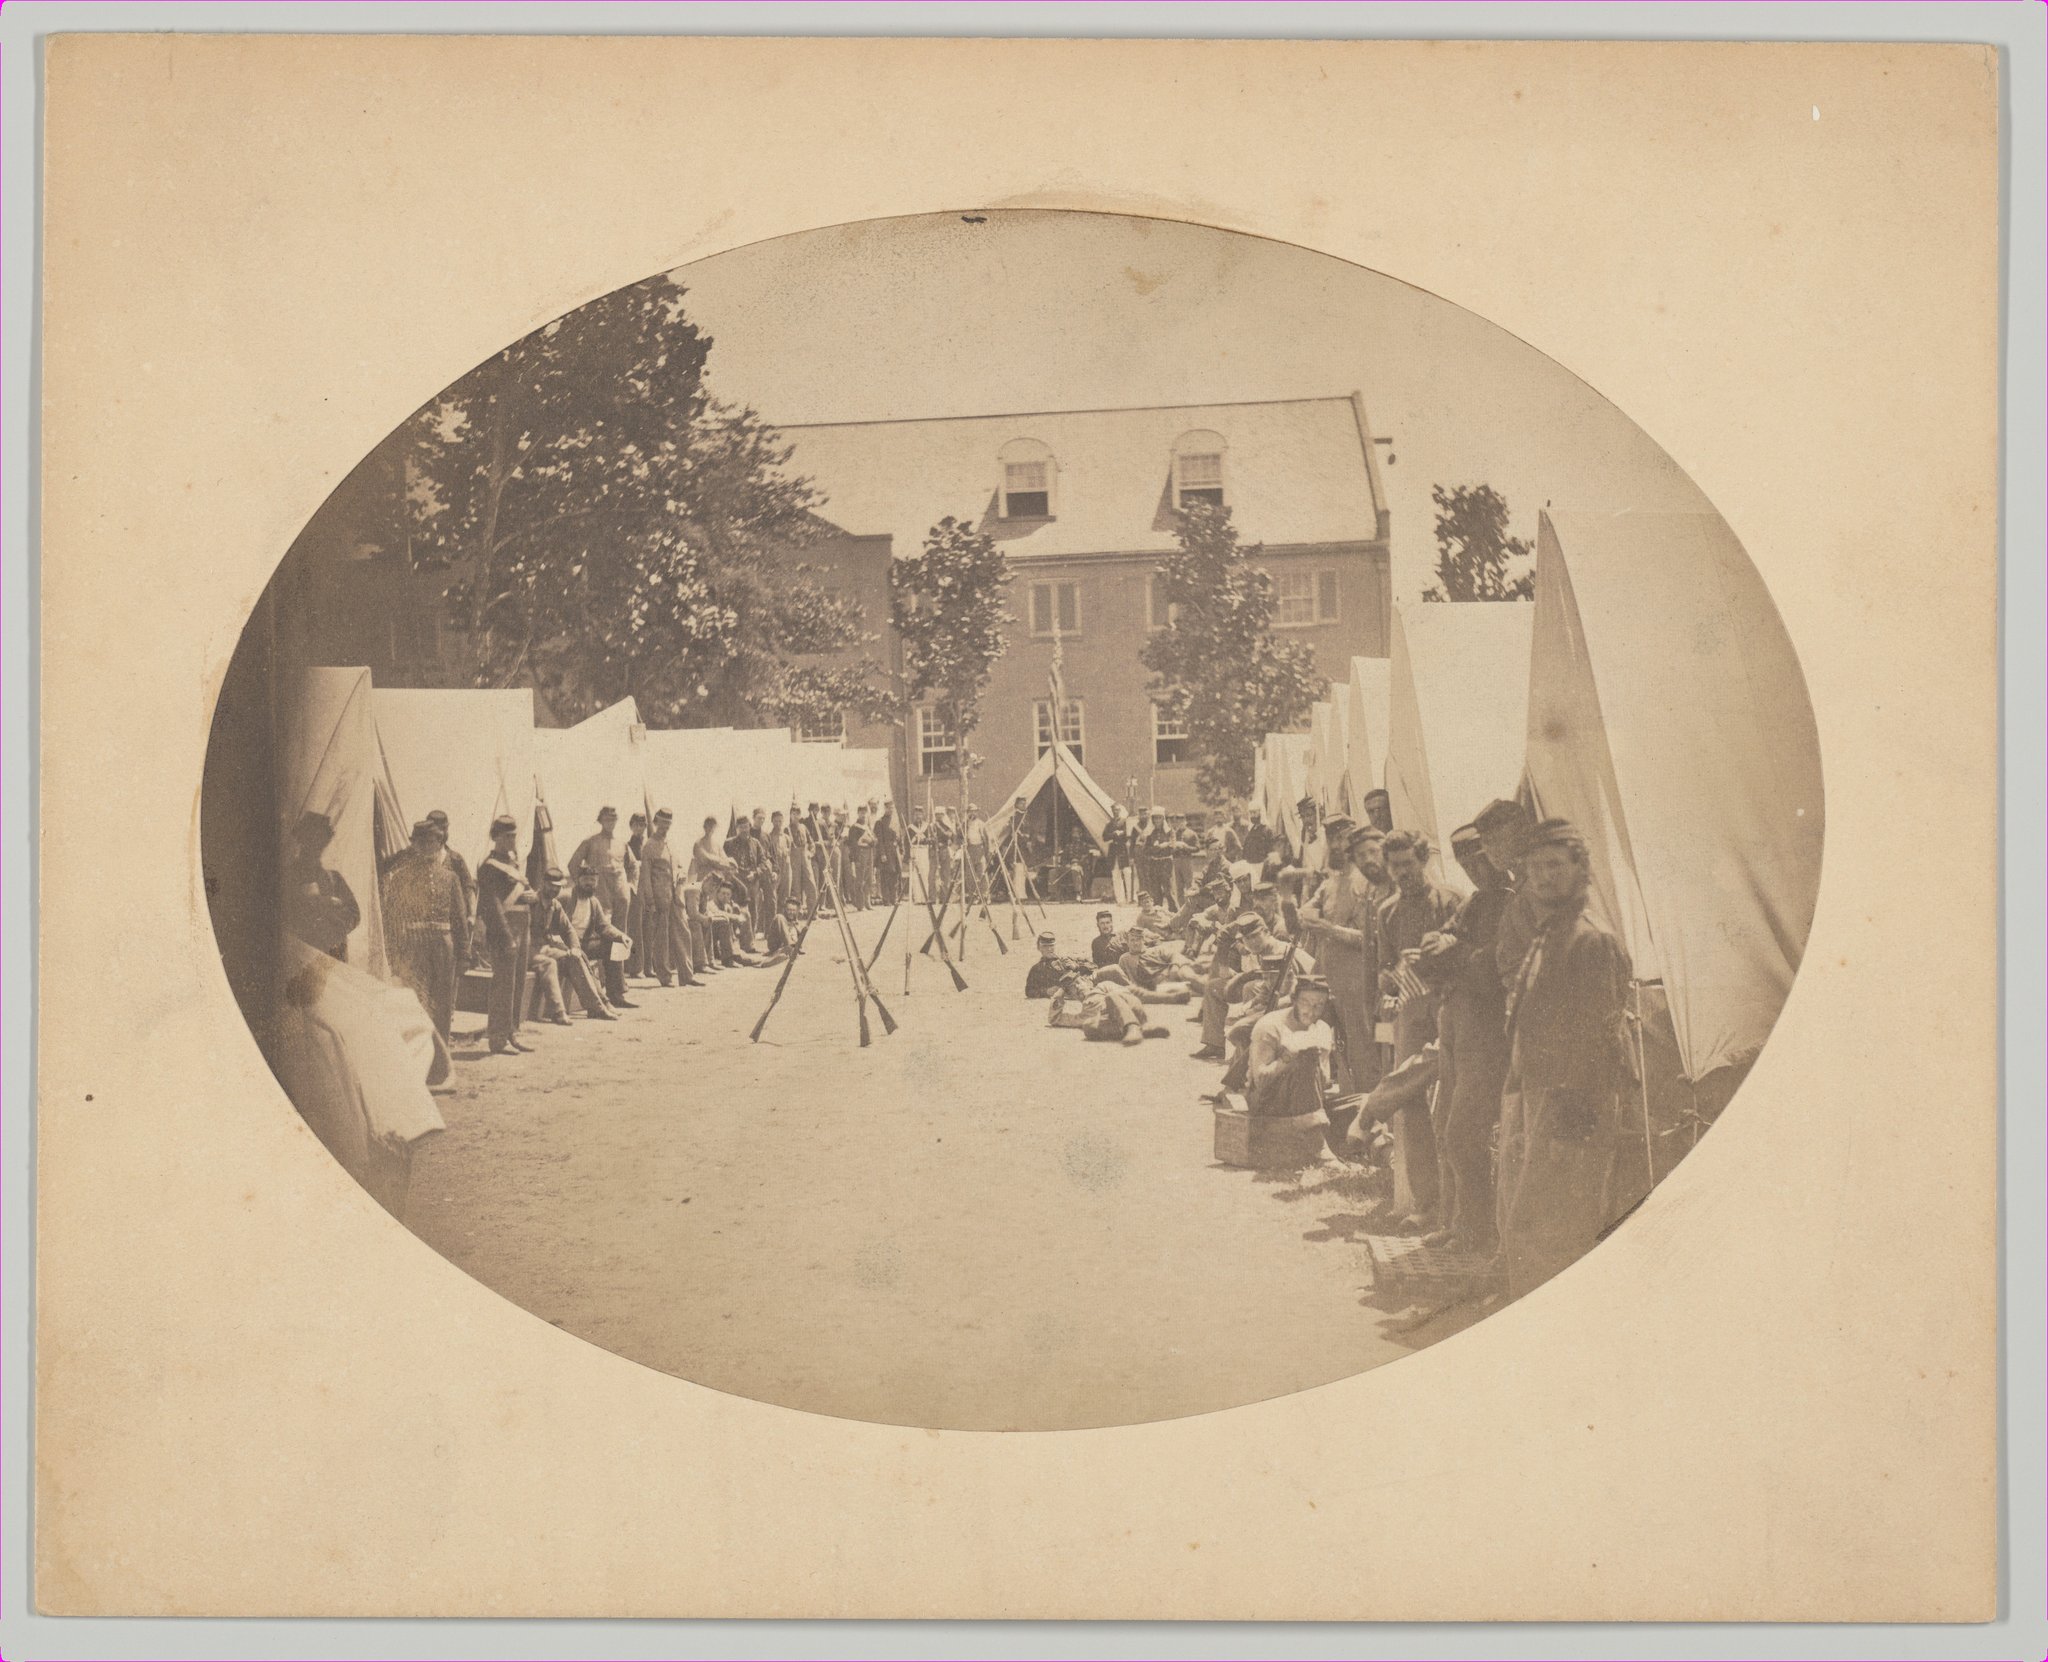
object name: photograph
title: [Encampment of 71st New York State Militia, Washington, D.C.]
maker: Anonymous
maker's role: artist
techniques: albumen silver print, glass negative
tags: american civil war